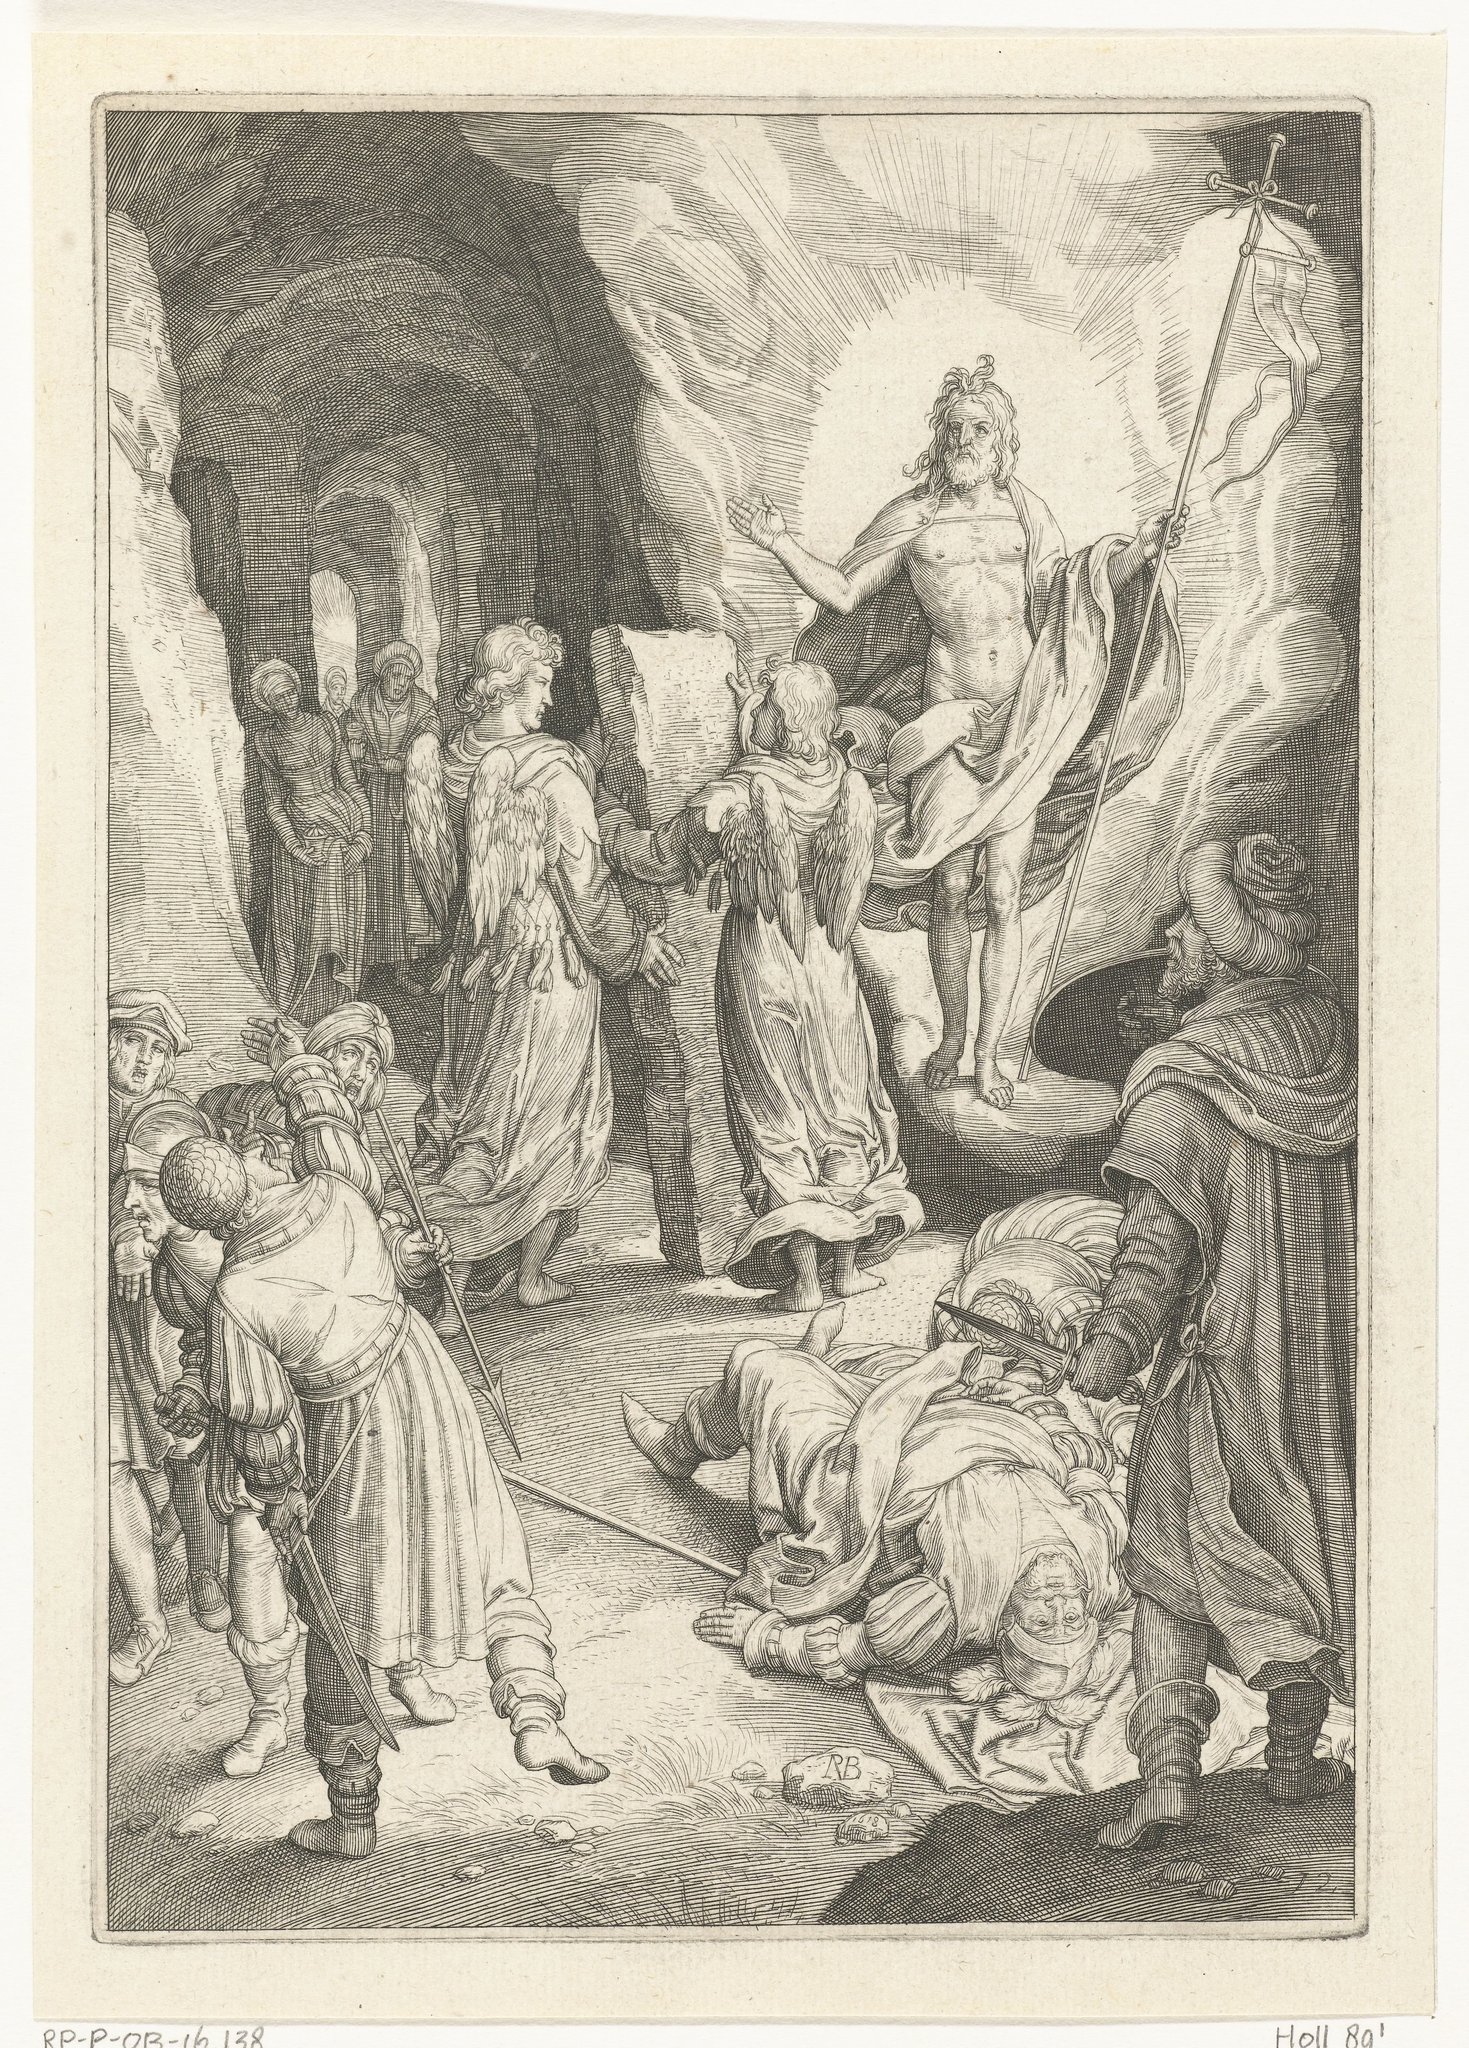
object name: print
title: Opstanding van Christus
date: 1618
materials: paper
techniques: engraving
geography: netherlands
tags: resurrection of christ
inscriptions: collector's mark: Lugt 2228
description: Christus staat in stralenkrans met kruisvaandel na opstanding uit zijn graf en engelen houden de deksel van zijn graftombe vast. Soldaten deinzen verschrikt naar achteren en in de gang van de grot naderen de drie heilige vrouwen.